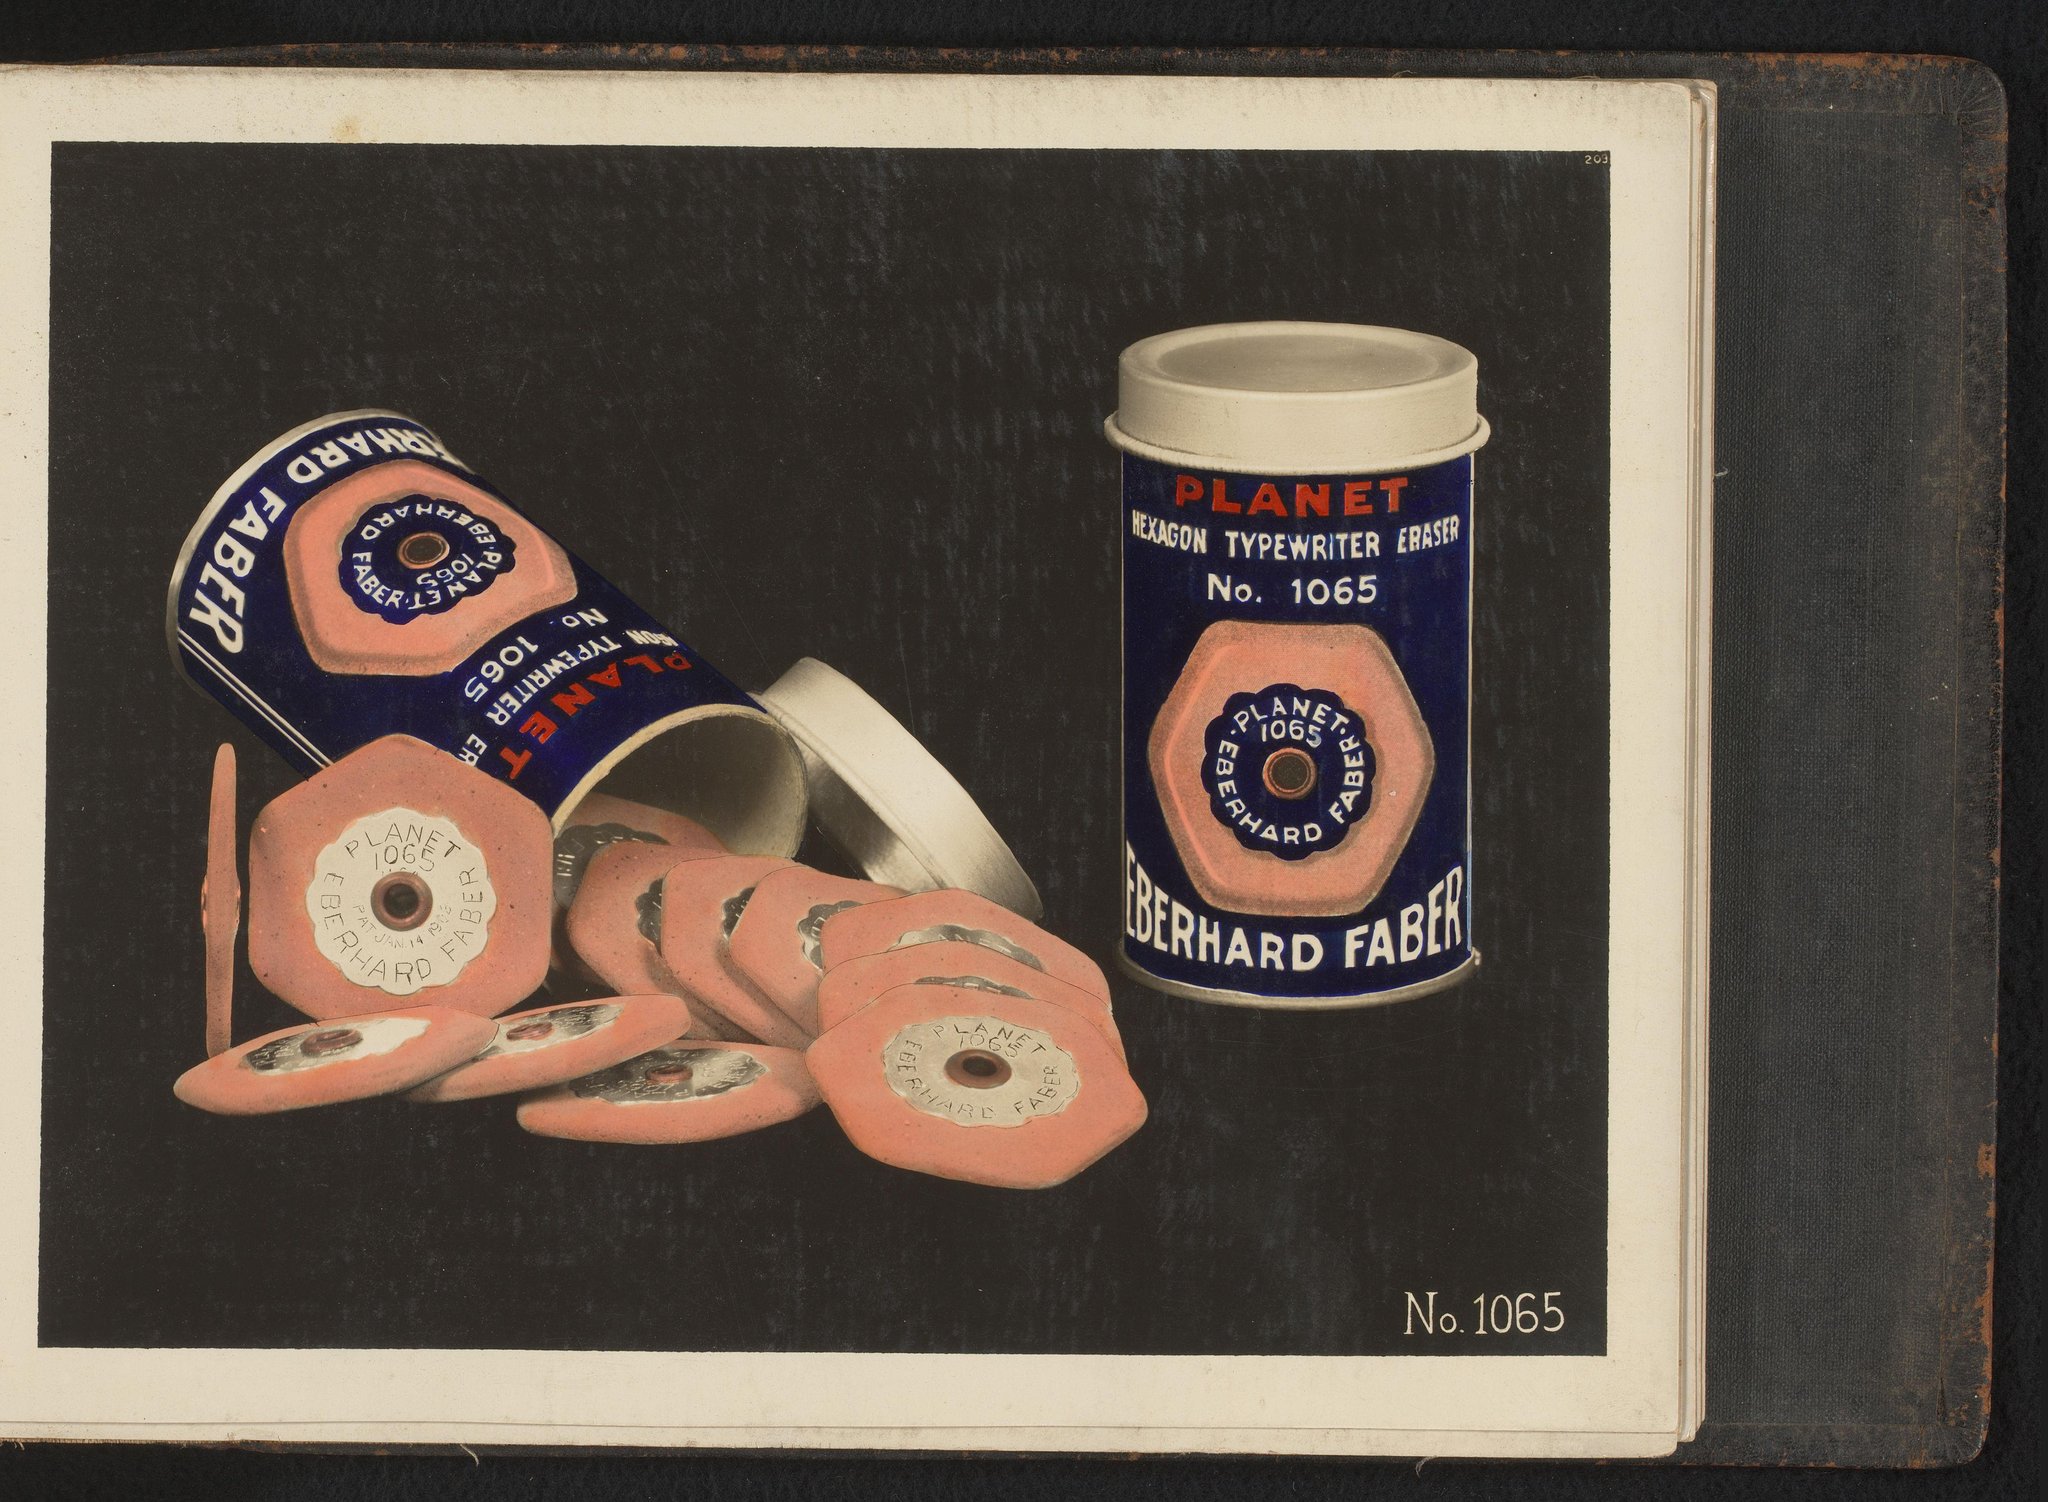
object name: photograph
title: Gummen van Eberhard Faber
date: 1915-1935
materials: paper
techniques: gelatin silver print, hand coloring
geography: springfield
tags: writing tools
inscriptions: stamp: ‘Paramount/ Commercial Studios/ 145 Chestnut St./ Springfield - Mass.’, number: ‘203’